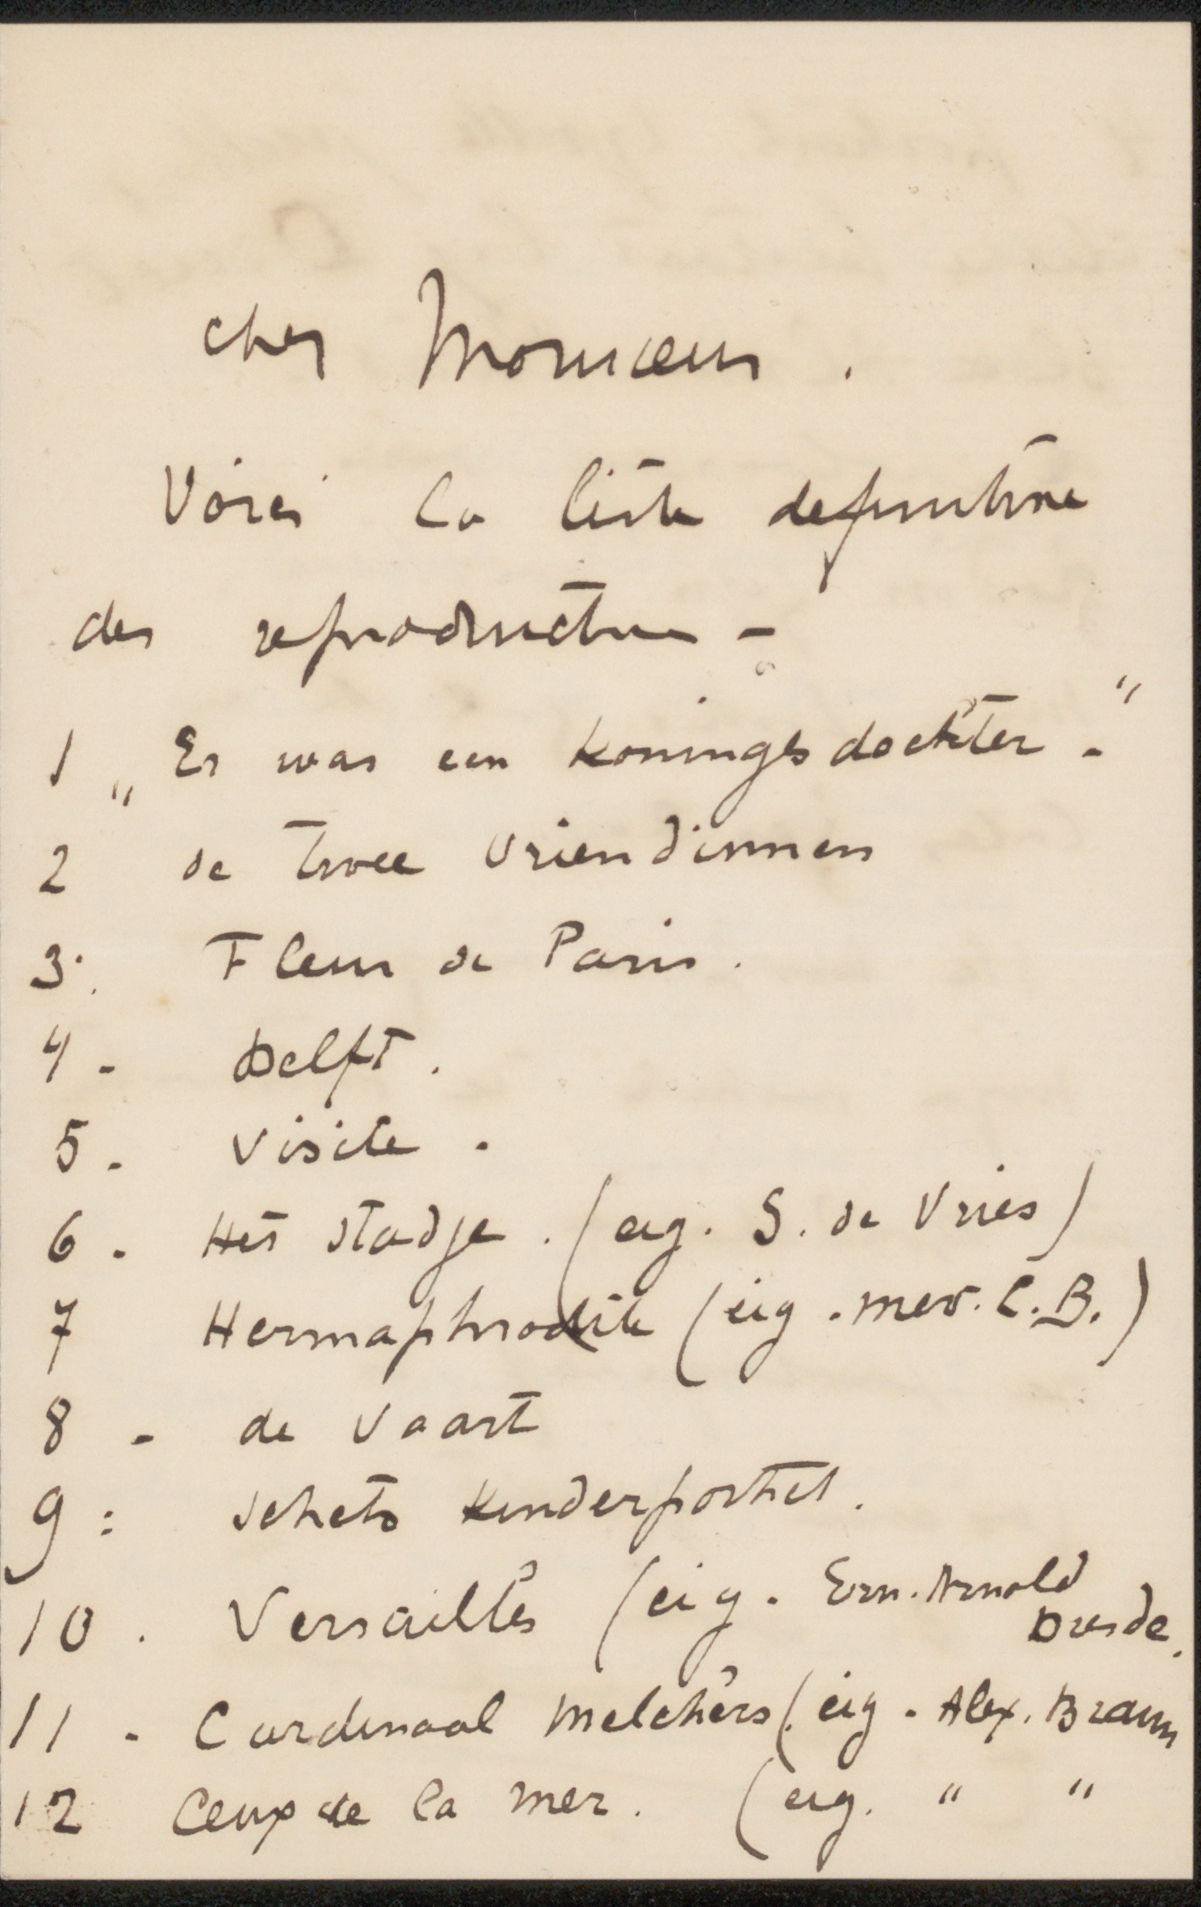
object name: letter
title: Brief aan Philip Zilcken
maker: franz melchers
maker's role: draughtsman, painter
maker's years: 1868-1944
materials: ink, paper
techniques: pen, writing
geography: delft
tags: dordrecht, dirk hidde nijland, charles emmanuel d'hoy, print maker, auguste rodin, paris, eugène druet, the hague, painter, philip zilcken, photography, cinematography, historical persons (portraits and scenes from the life), printed matter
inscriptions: collector's mark: ‘RPK’, watermark